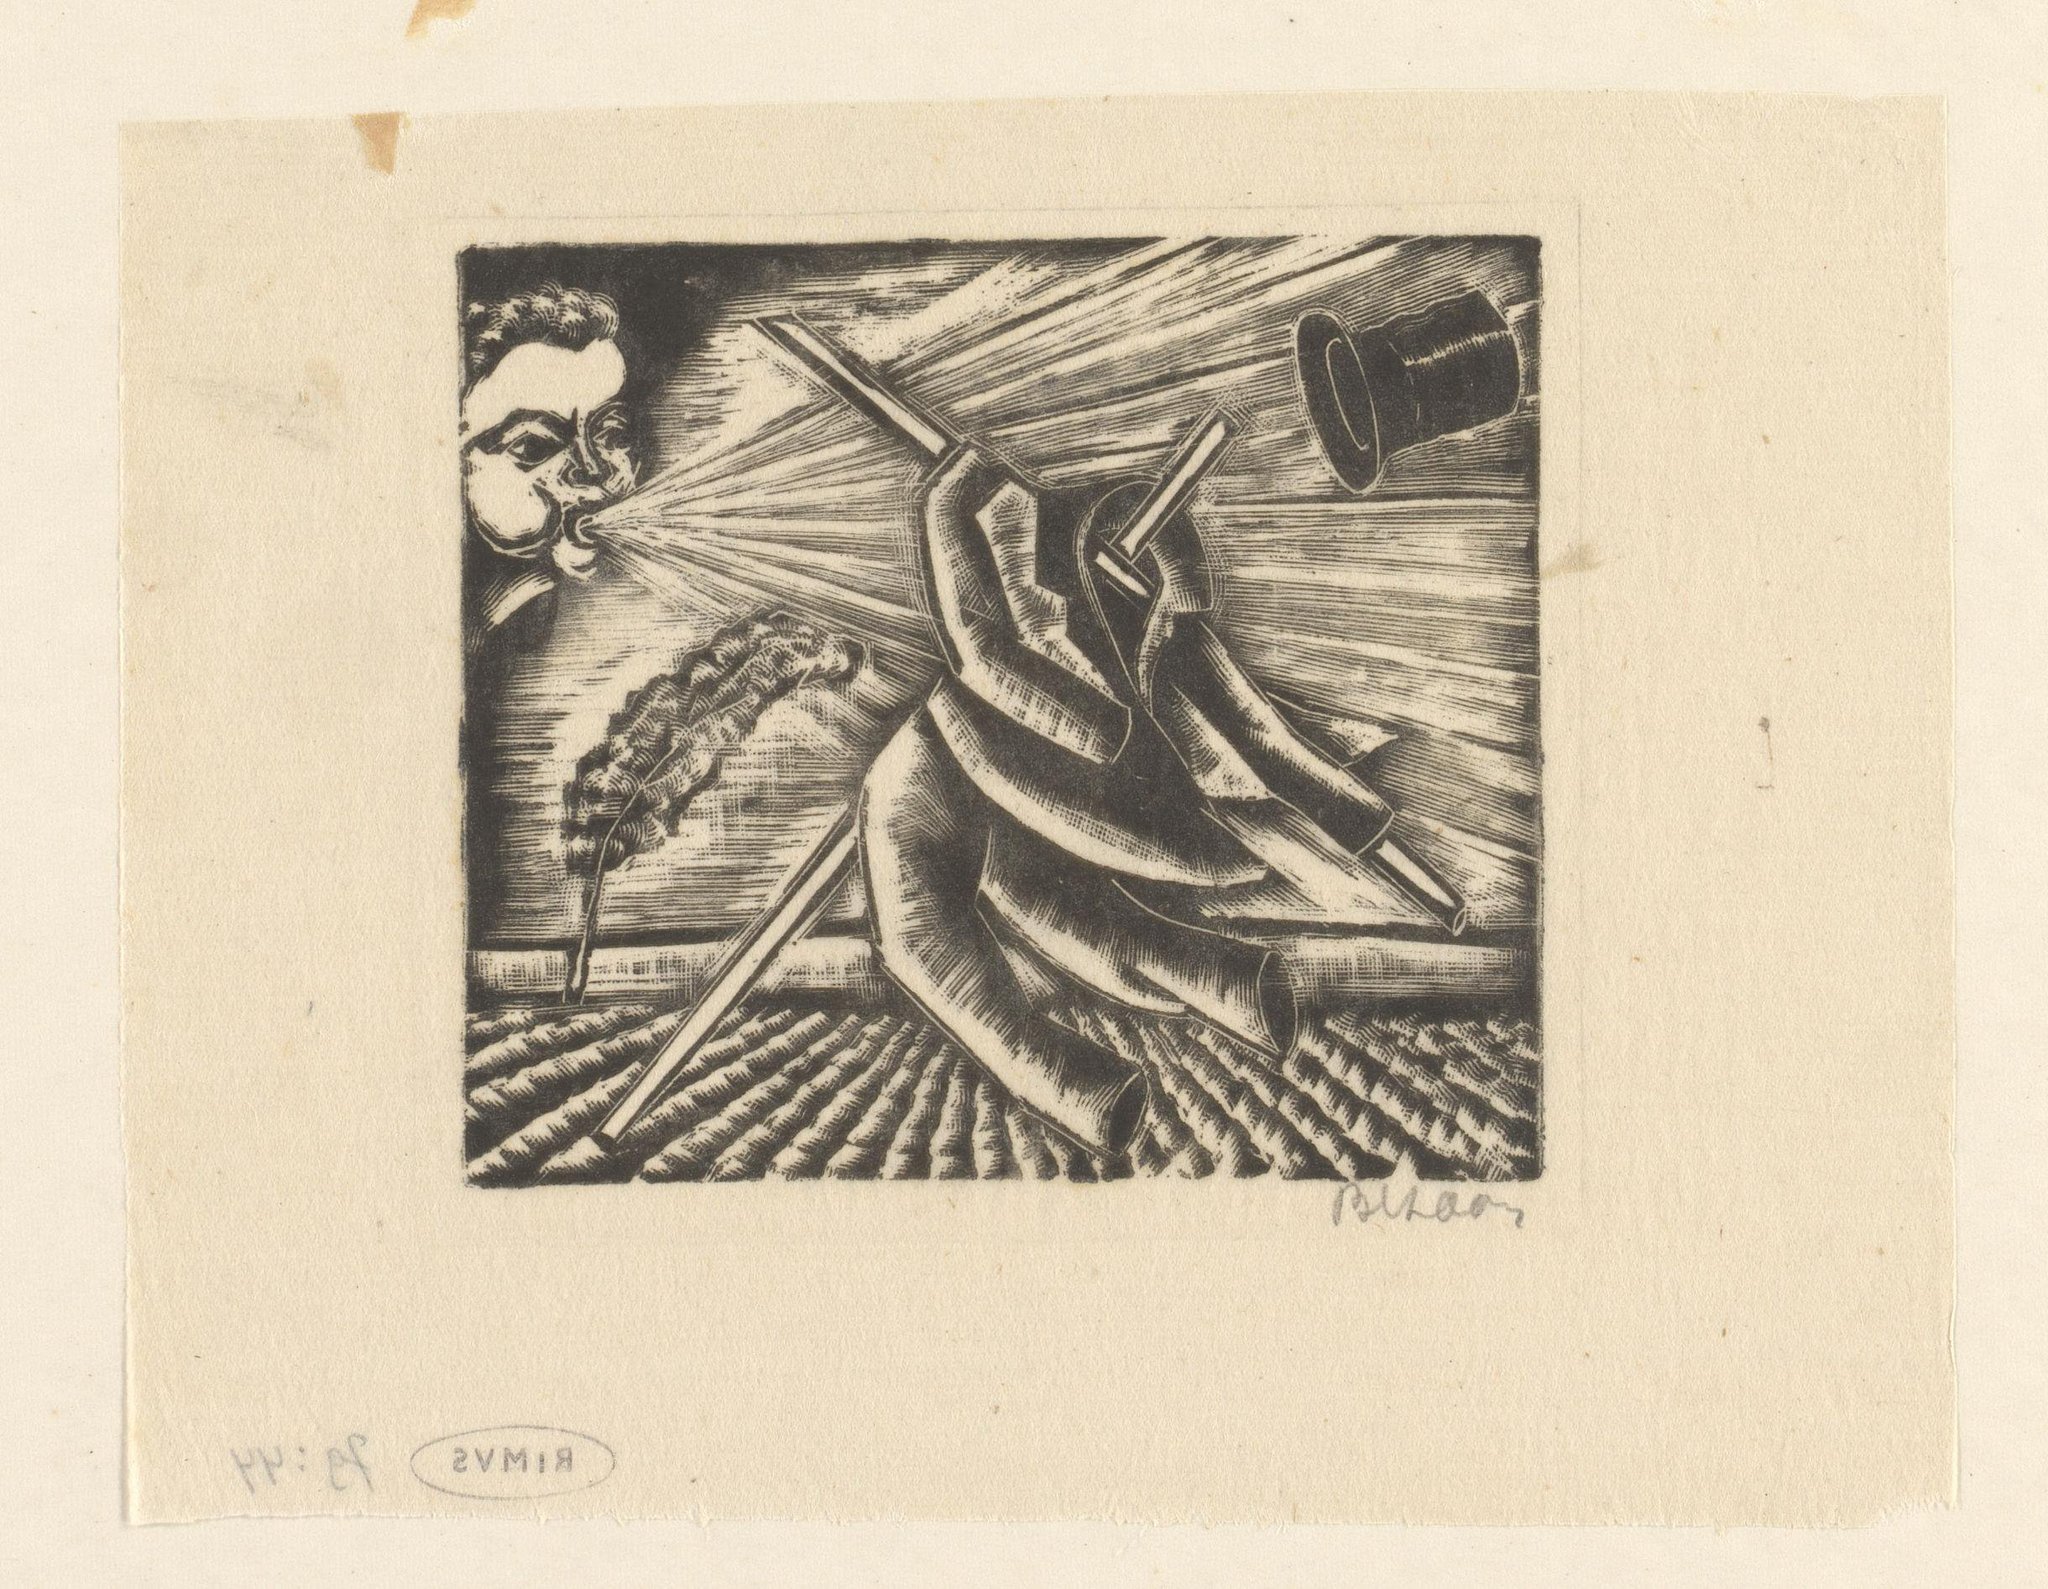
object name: book illustration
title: De vogelverschrikker I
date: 1941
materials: paper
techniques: engraving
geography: putten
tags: wind as a human face, blowing with rounded cheeks, scarecrow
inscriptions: collector's mark: Lugt 2228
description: Prent gebruikt voor: Hattum, Jac. van. Van Odrimond, Millimas en anderen. Putten: D.J. Terwee, [1941].